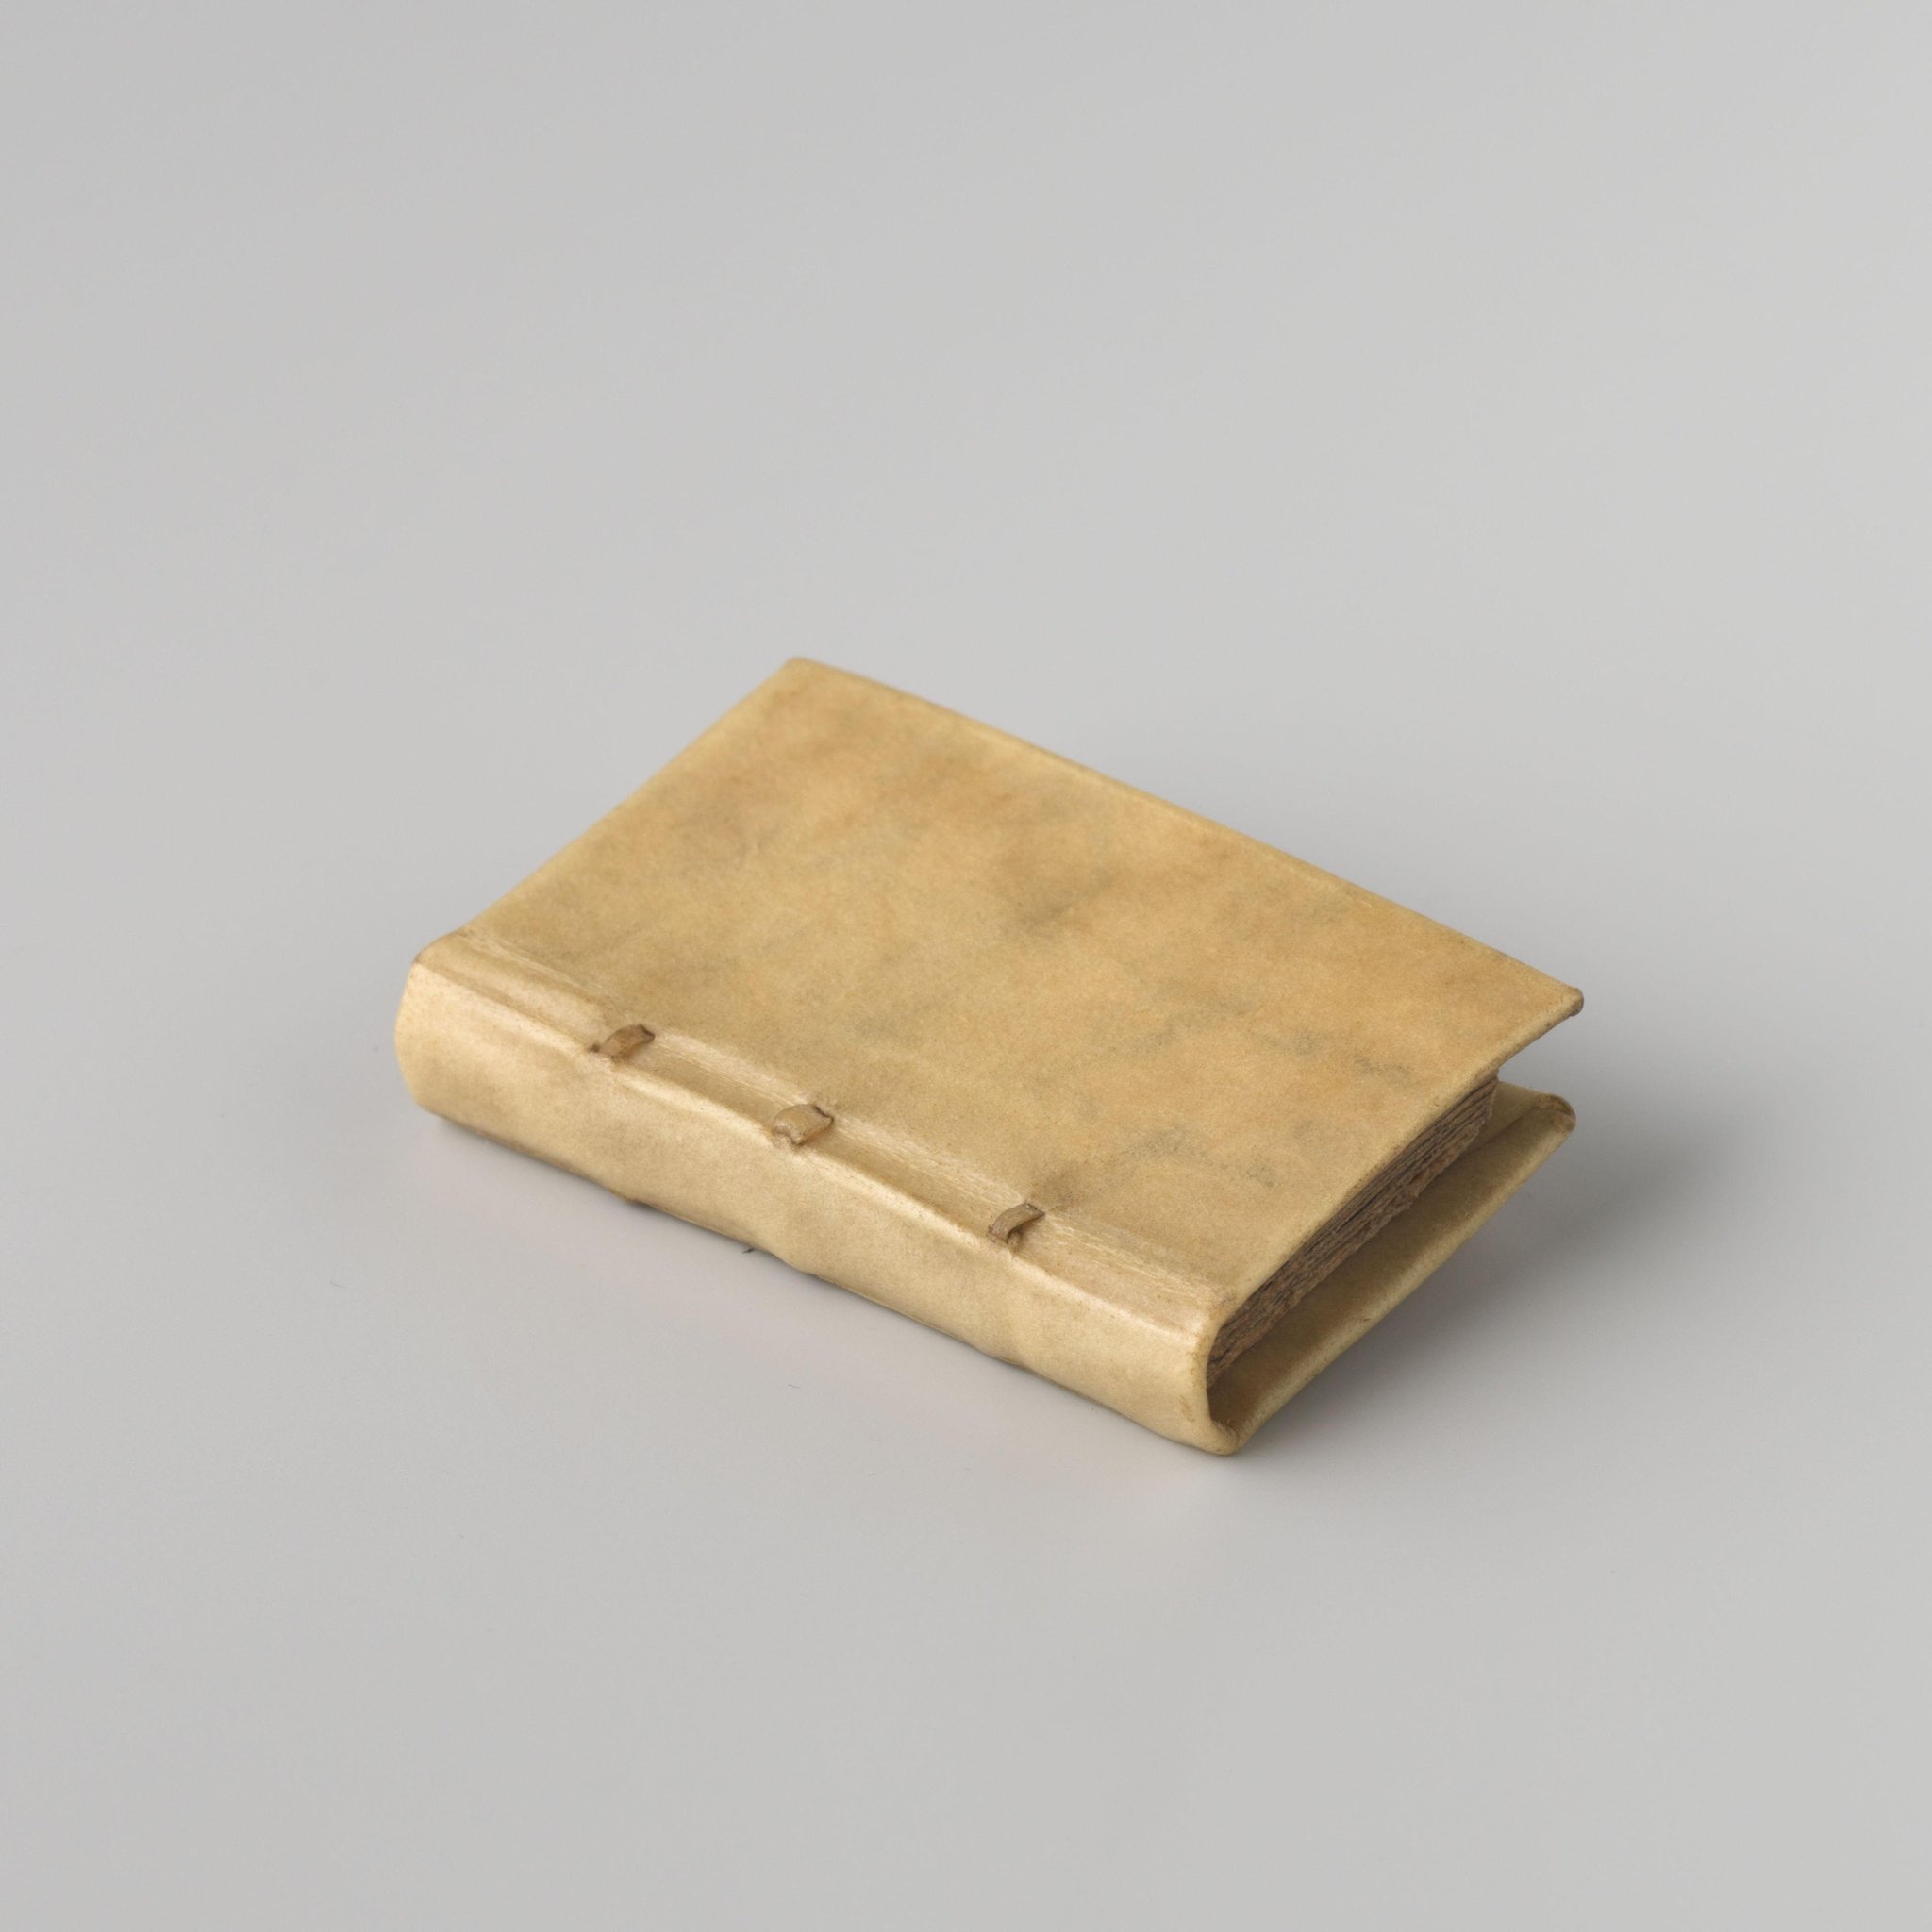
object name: album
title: Van de Pausen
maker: Anonymous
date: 1676-1689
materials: paper, parchment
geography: amsterdam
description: Eén van 6 boeken uit een serie van oorspronkelijk 10; gebonden in blank perkament (zg. splitsel binding), hergebruikt (makulatuur) snede, ongekleurd. 4 katernen van 4 plakstroken. De bladzijden zijn aan de plakstroken geplakt recto en verso, geknipt uit een langestrook met koppen van 25 pausen, voorafgegaan door geschreven tekst: Omnium pontigicuma S. Petro Usque an Praesentem effigies ab antiquis diligenter extractus. "Het derde deel van de Pausen". Uitgeknipt uit een tussen 1676 en 1689 uitgegeven prent.